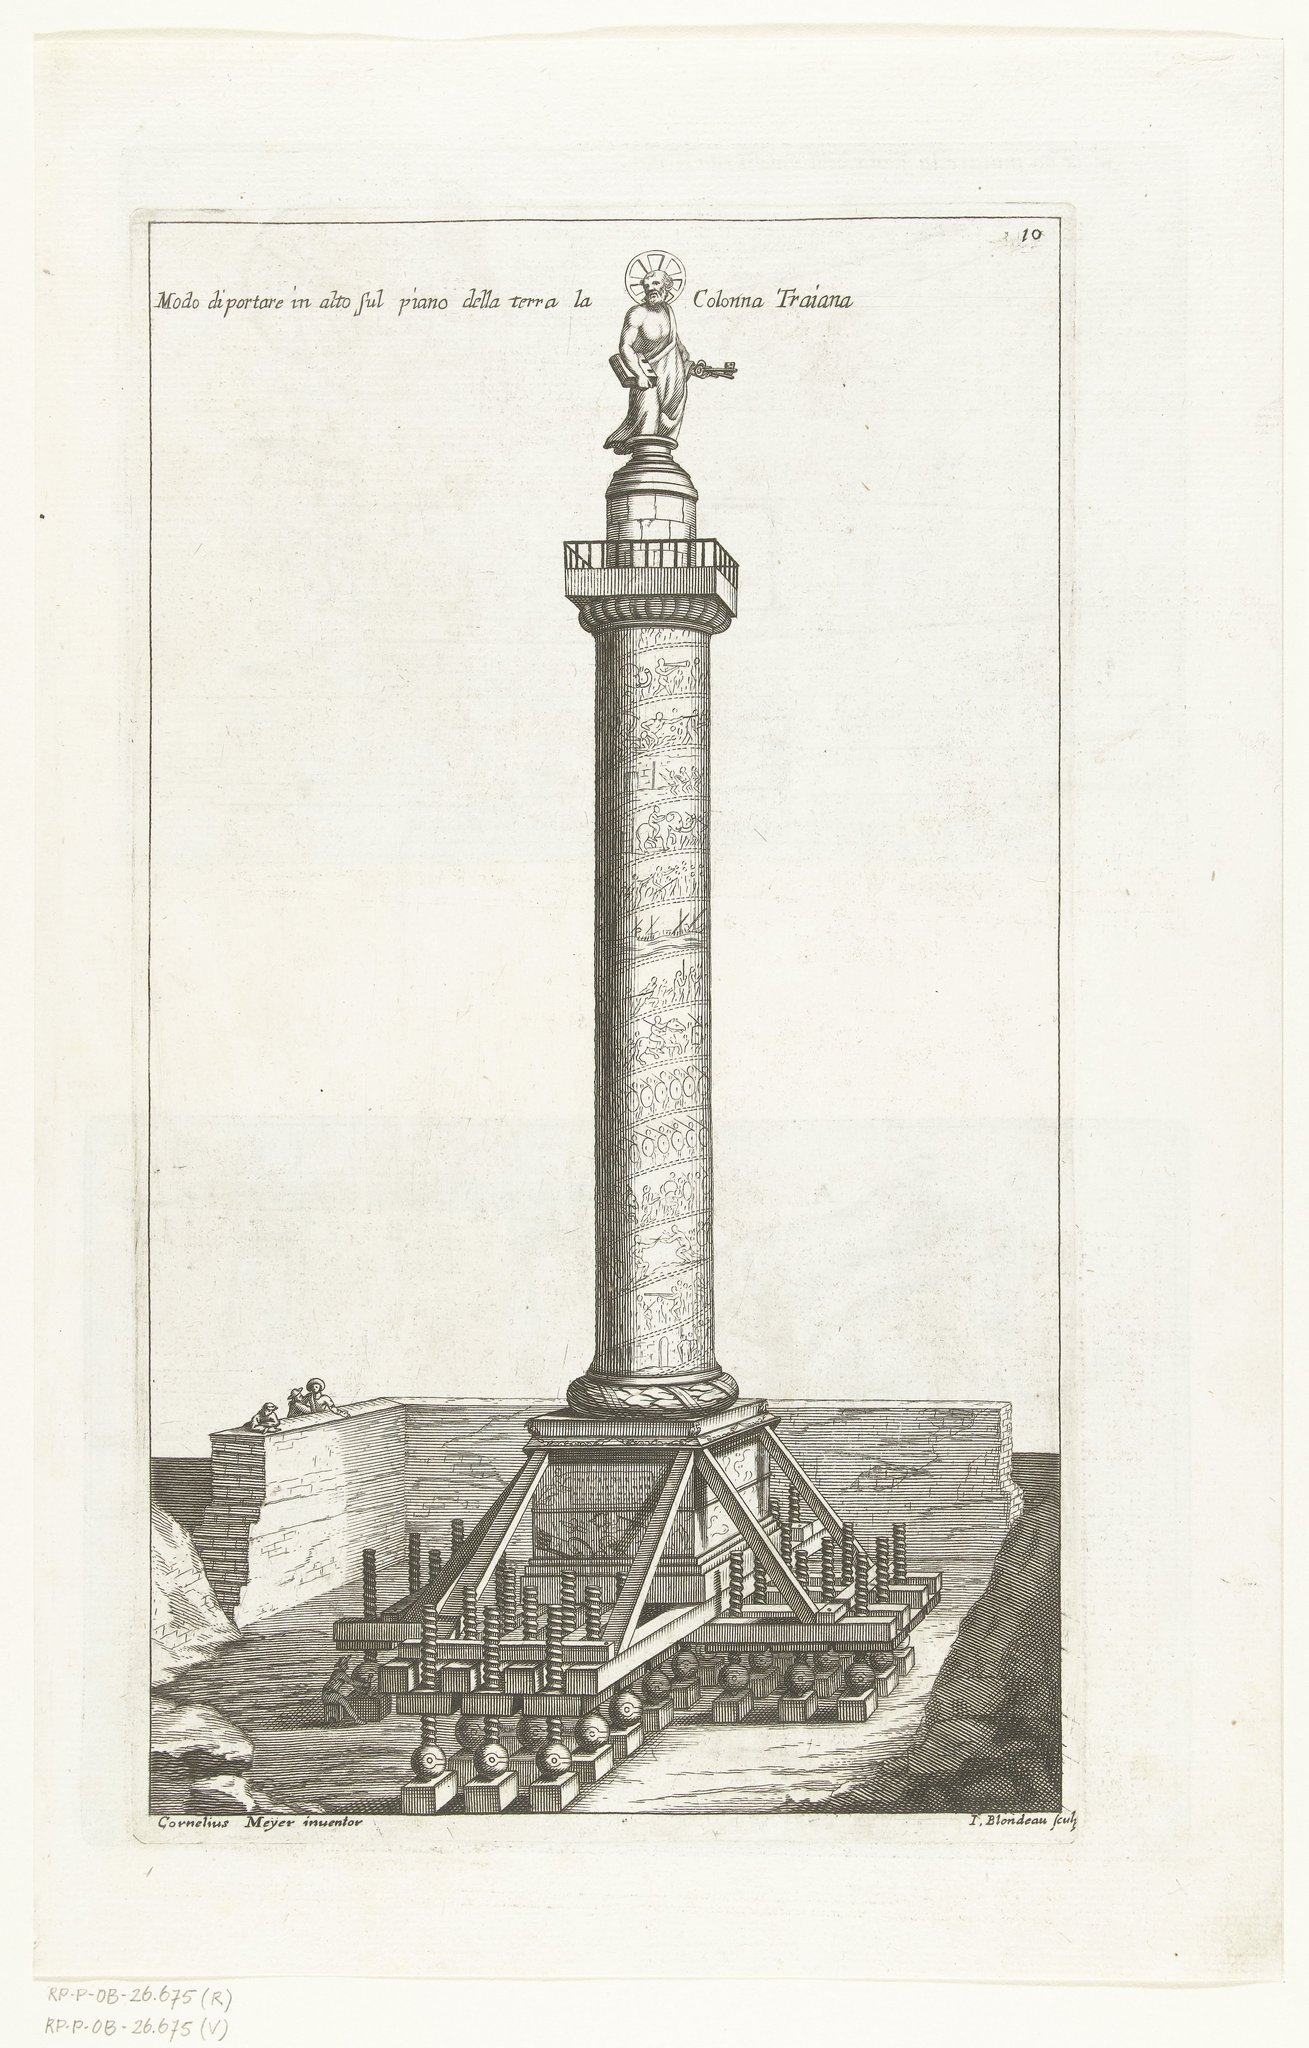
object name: print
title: Modo di portare in alto sul piano della terra la Colonna Traiana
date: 1665-1698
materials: paper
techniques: engraving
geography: netherlands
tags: restoration of a work of art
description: Prent gebruikt als boekillustratie in onbekende uitgave.